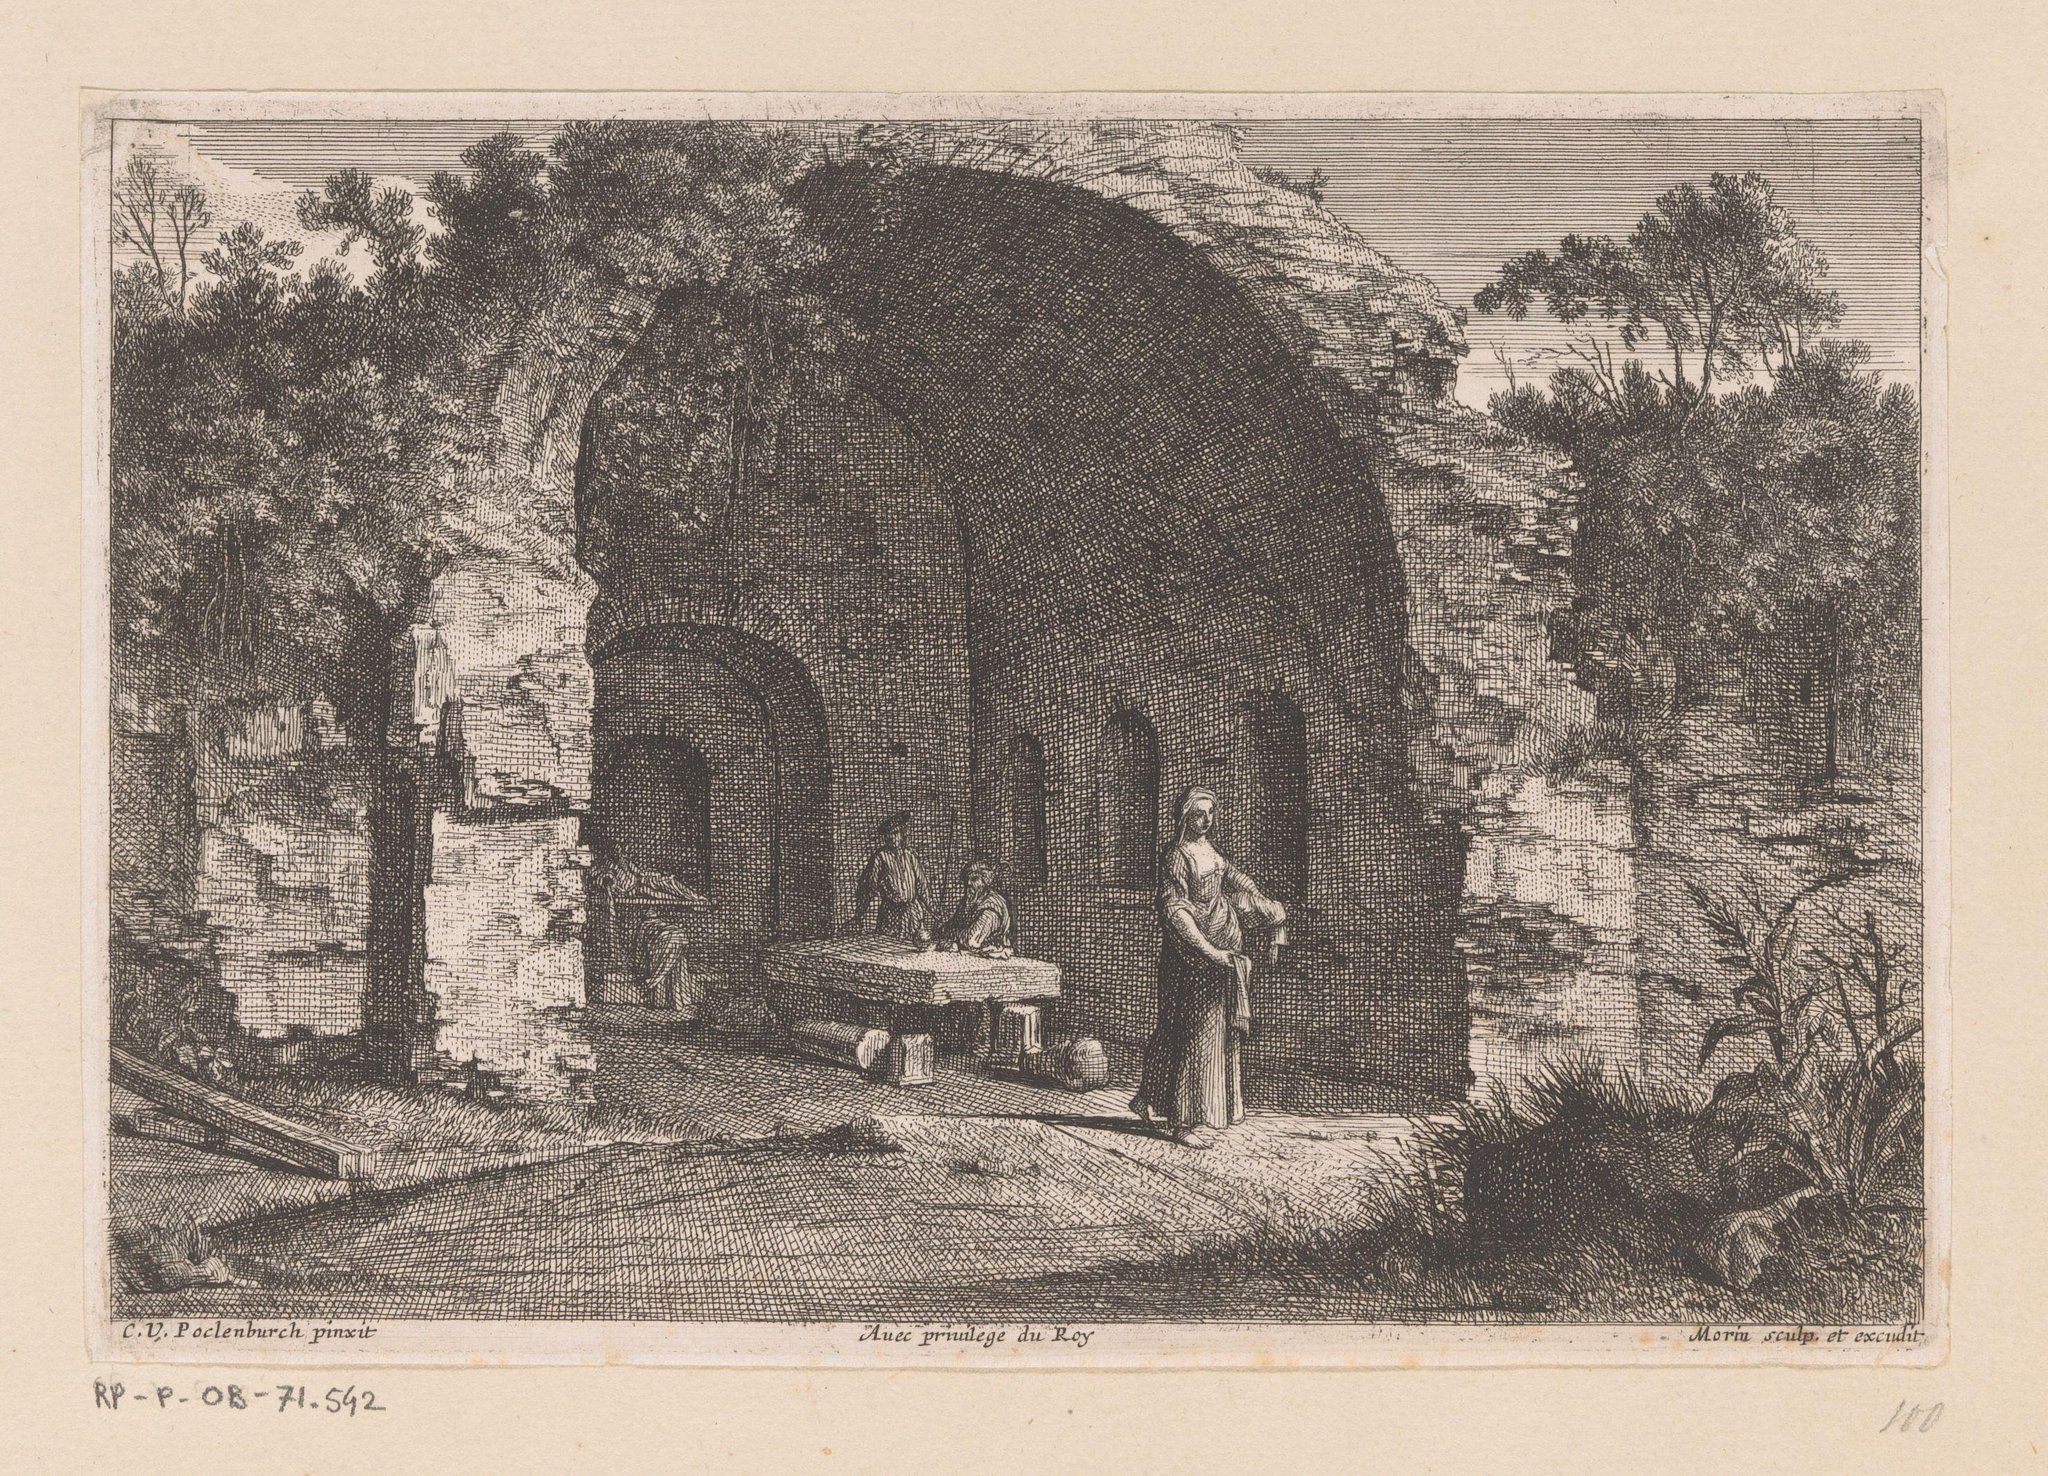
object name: print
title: Gezicht op een gewelf van de fontein Ninfeo d'Egeria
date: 1625-1650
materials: paper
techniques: etching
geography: paris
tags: landscape with ruins, landscapes in the temperate zone (+ landscape with figures, staffage)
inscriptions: collector's mark: Lugt 240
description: Maakt deel uit van een vierdelige serie met Italiaanse landschappen met ruïnes.